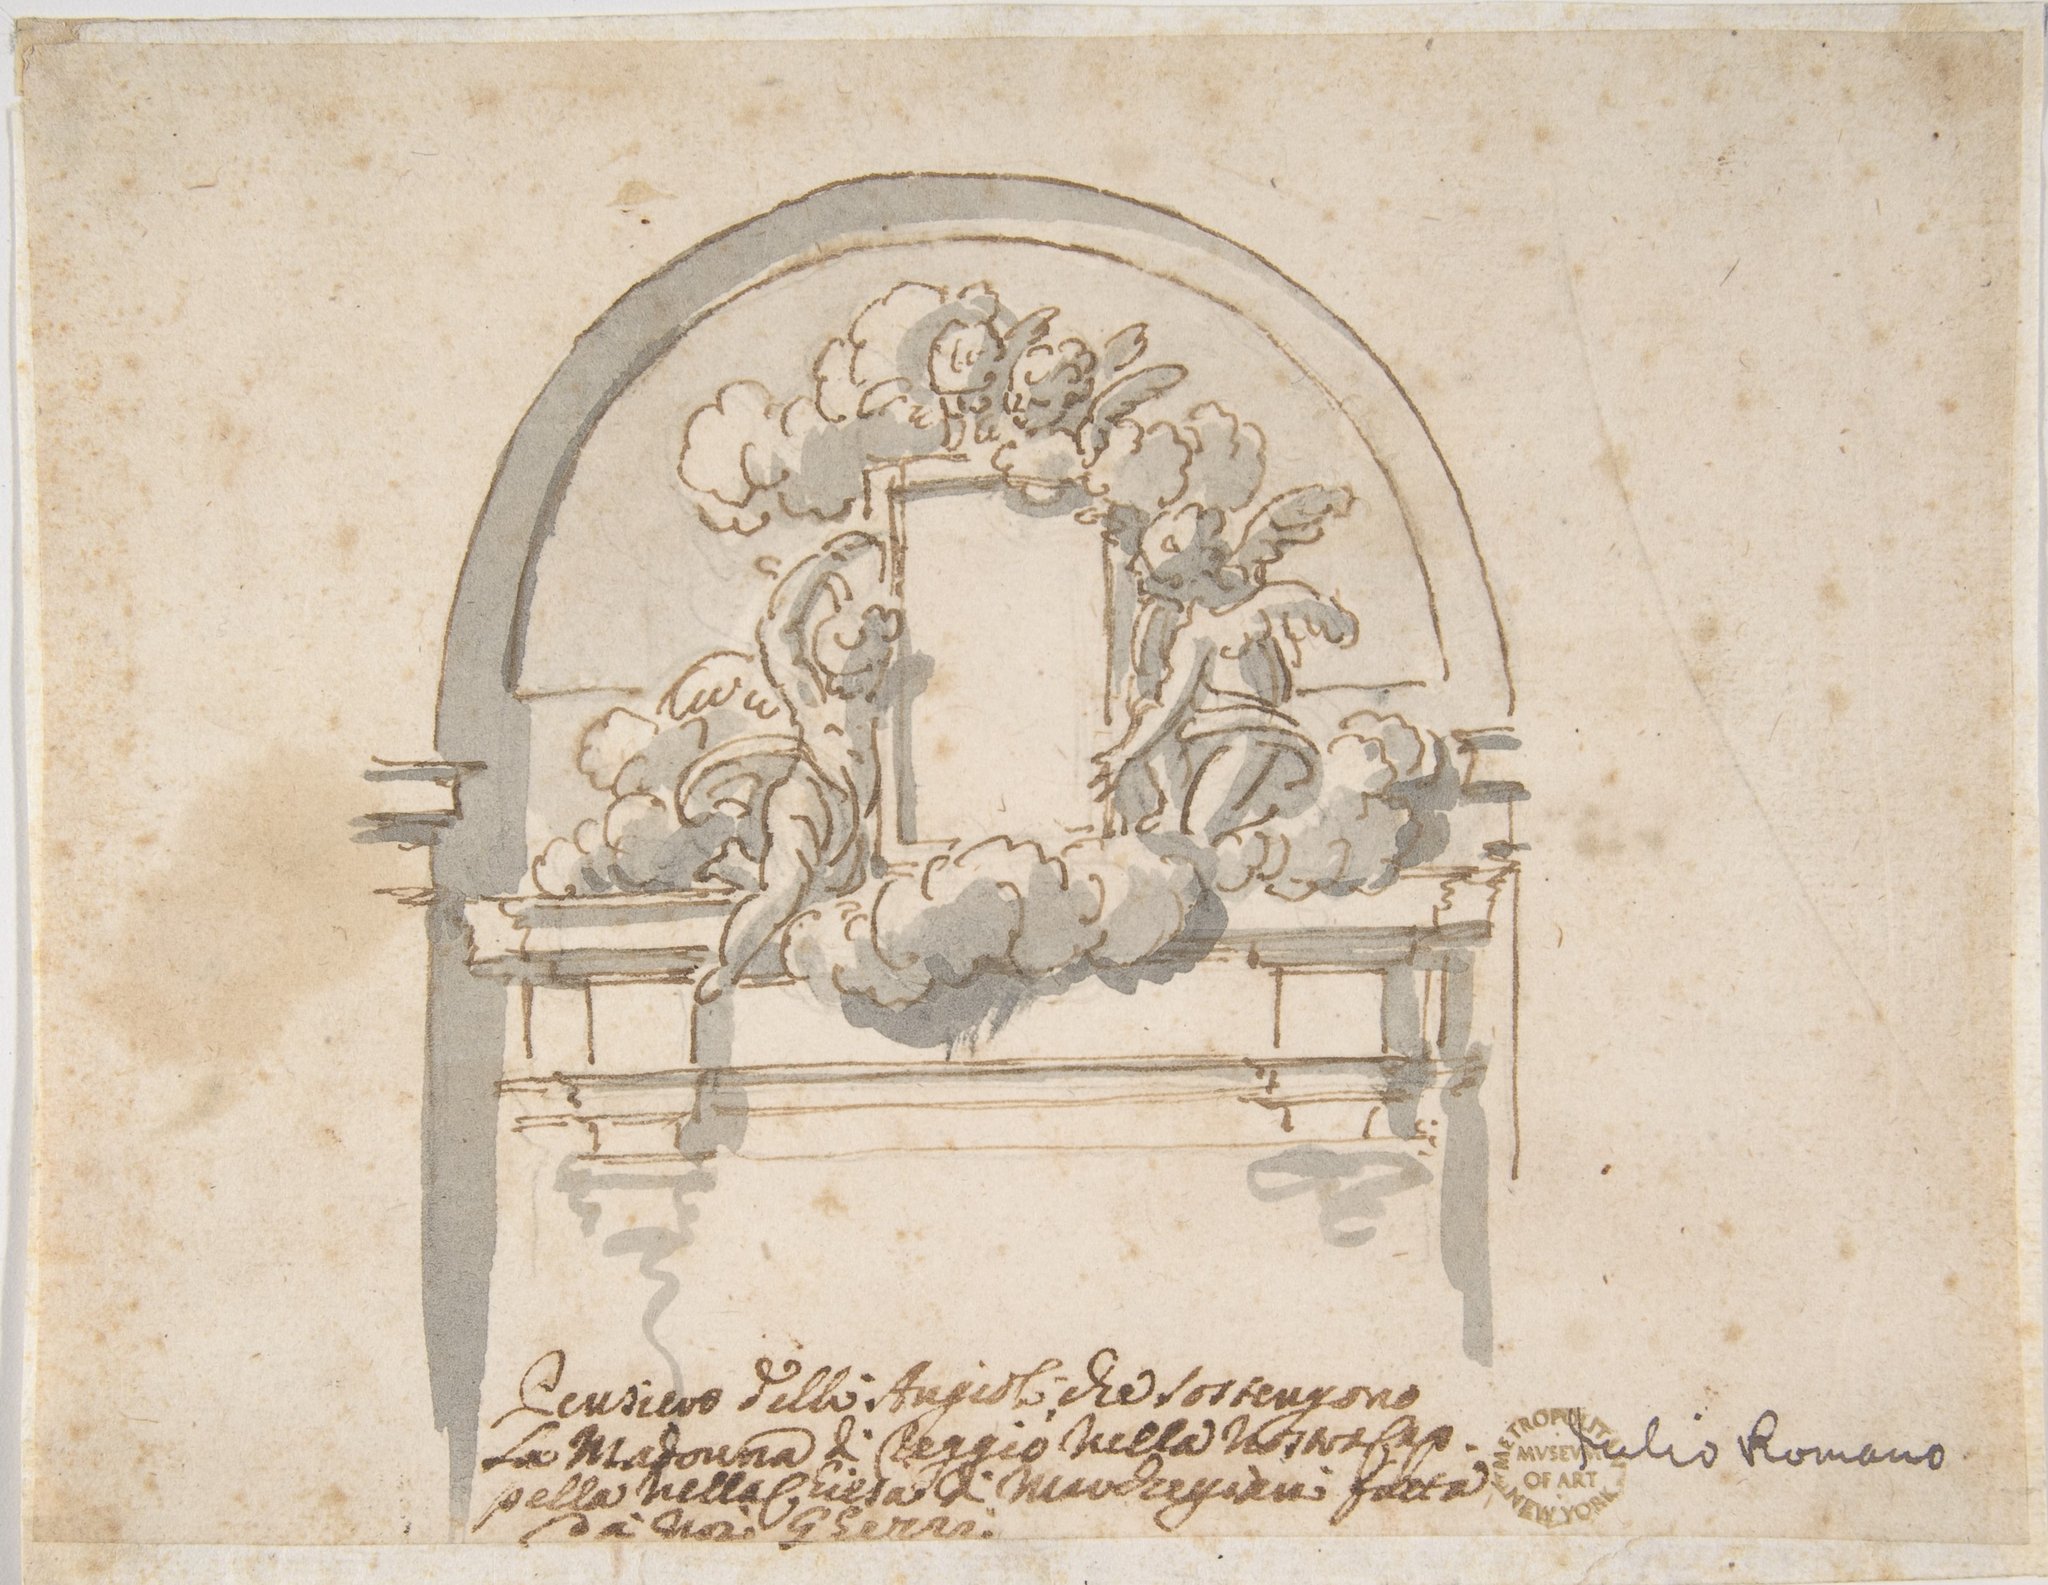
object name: drawing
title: Angels Supporting a Frame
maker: pier leone ghezzi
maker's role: artist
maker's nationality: italian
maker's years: 1674-1755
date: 1674-1755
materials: graphite, ink, lead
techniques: brush, pen, wash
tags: angels